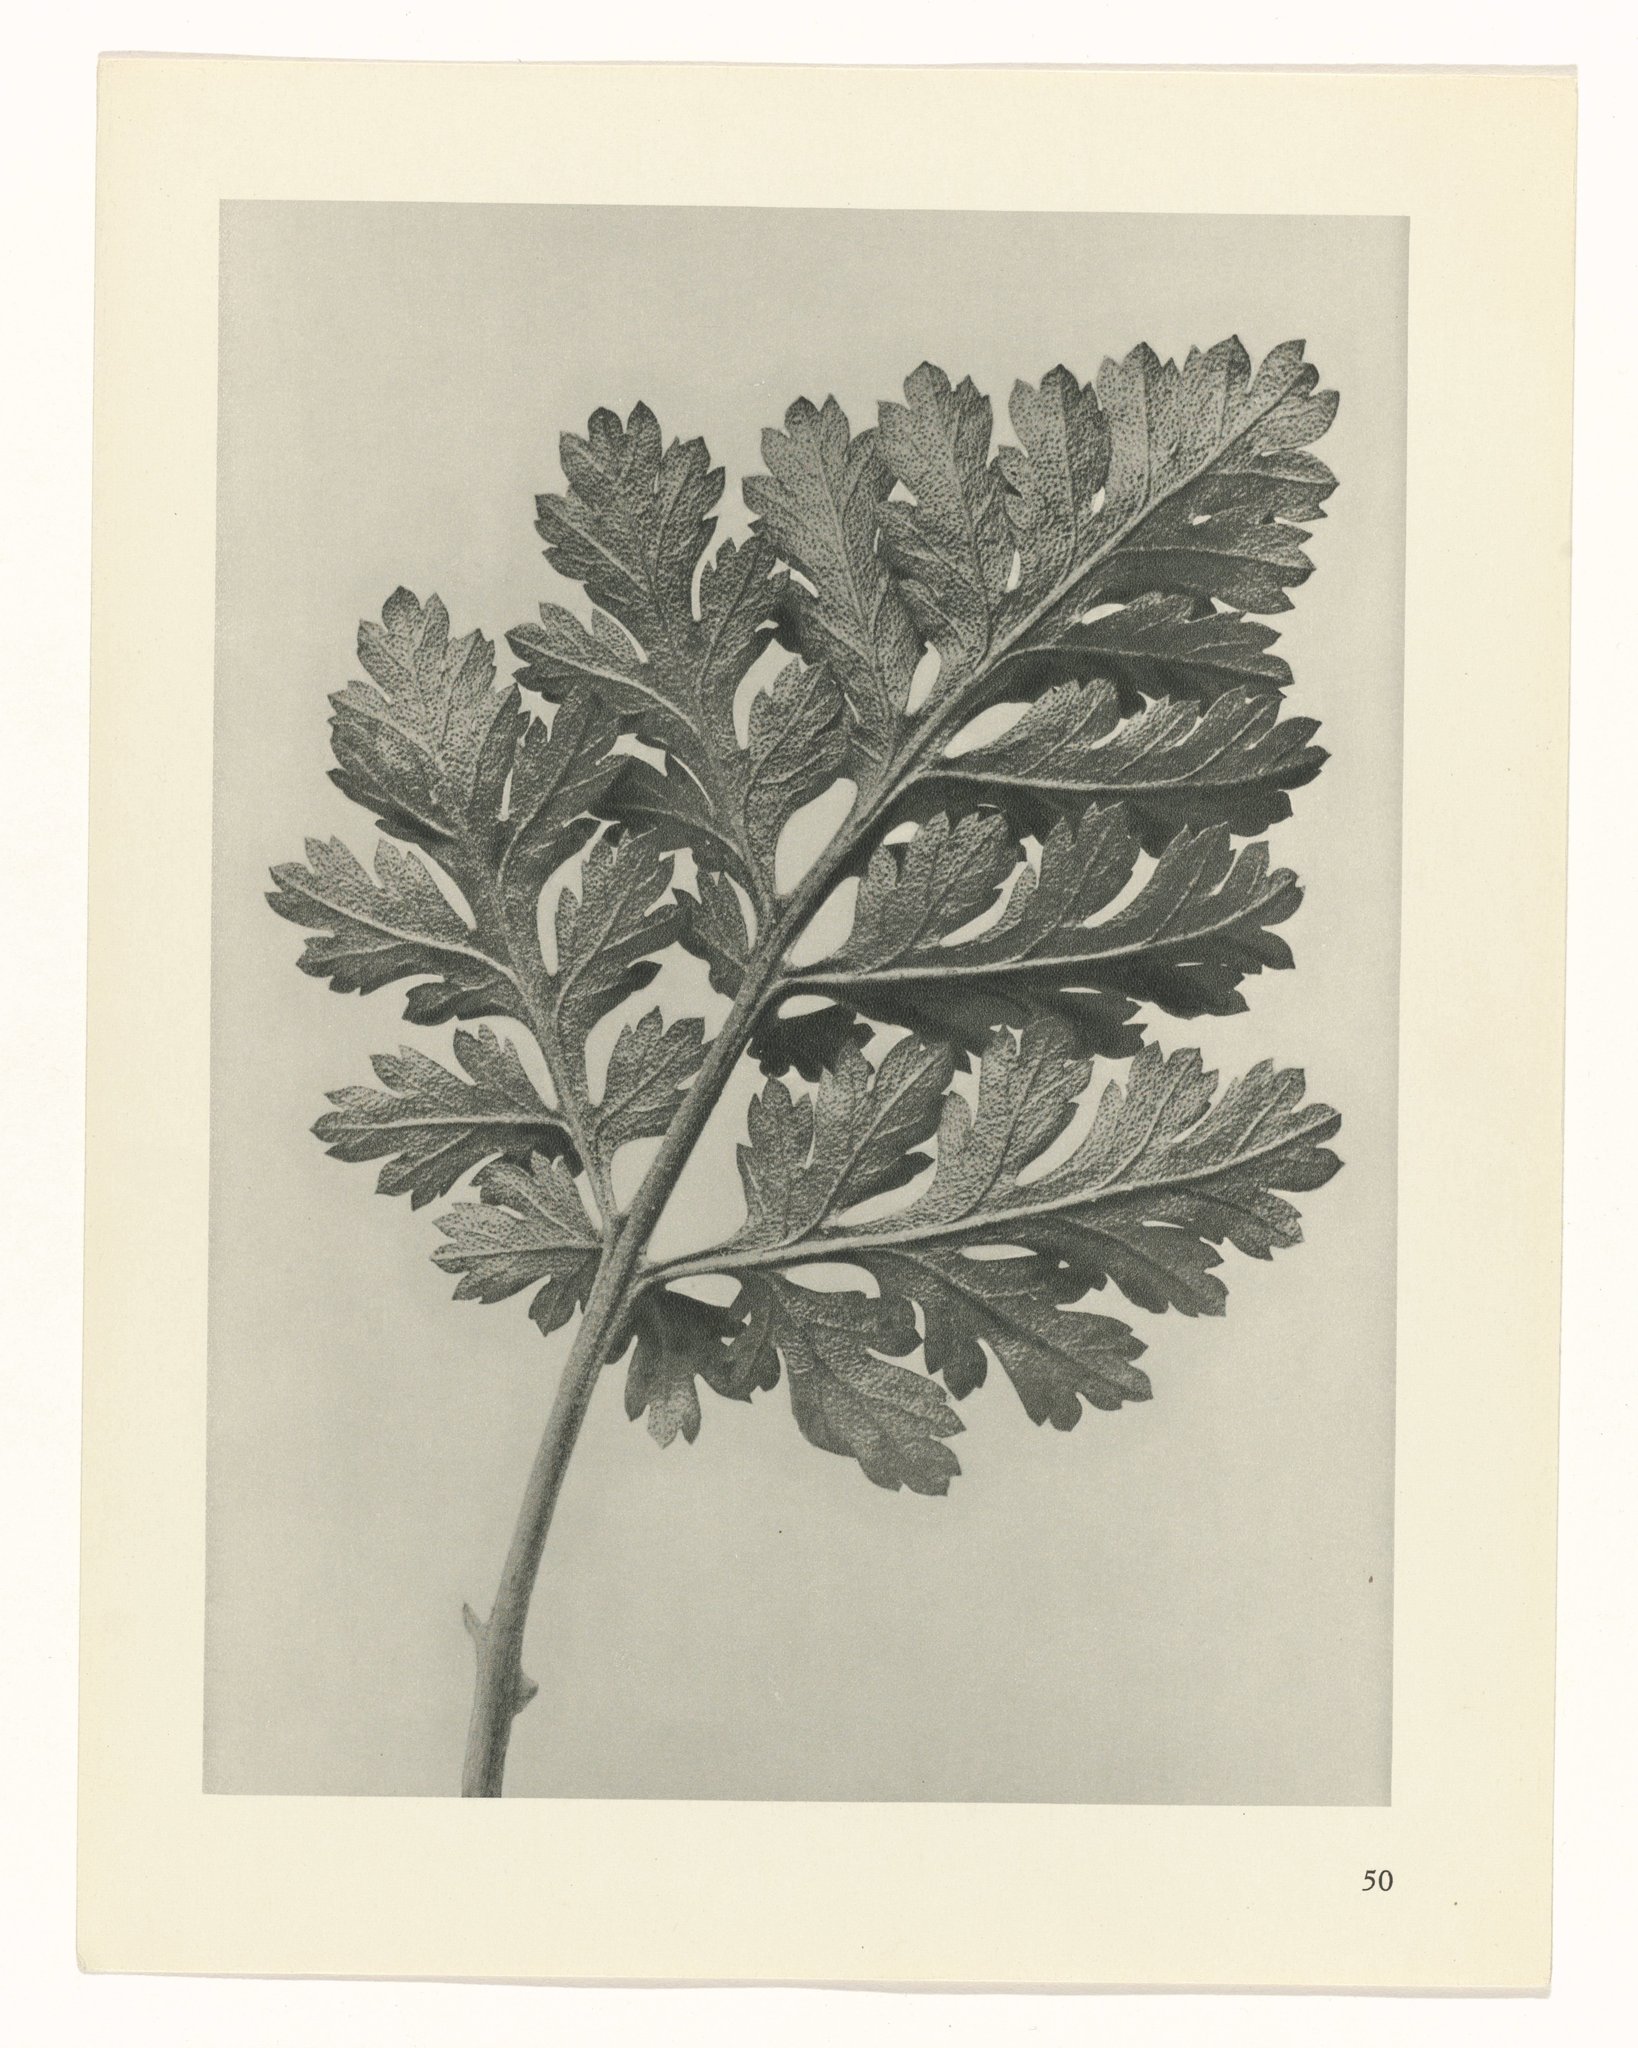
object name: photograph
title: Plantstudie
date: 1928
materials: ink, paper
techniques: rotogravure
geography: berlin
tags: plants (in general)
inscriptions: number: ‘50’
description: facher Vergrößerung. Afkomstig uit losbladige uitgave.